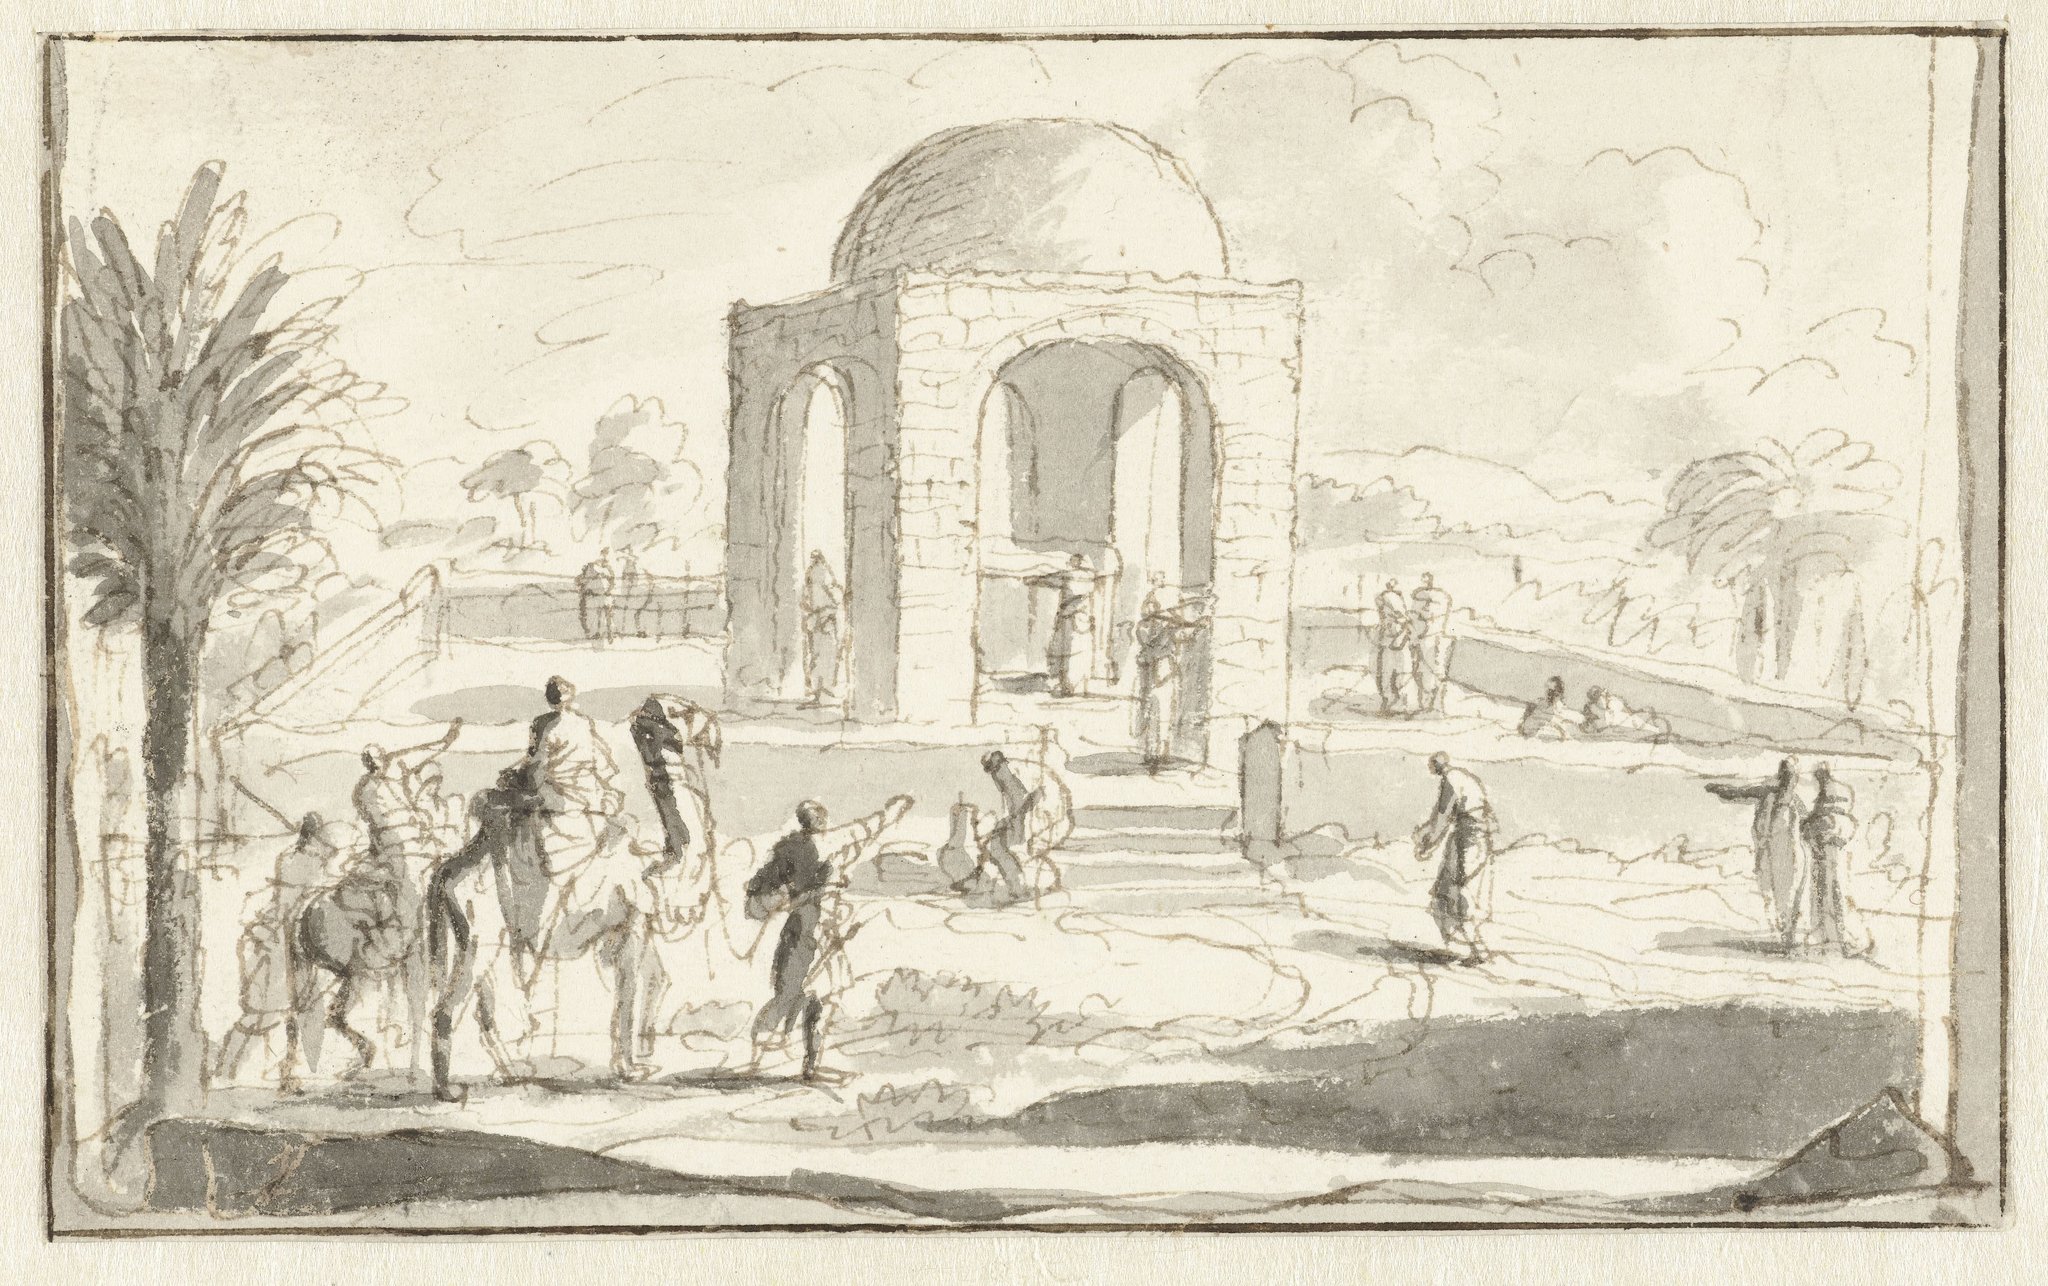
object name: drawing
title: Gezicht op een moskee of tempel in de woestijn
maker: jan luyken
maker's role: draughtsman, print maker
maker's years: 1649-1712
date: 1660-1712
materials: ink, paper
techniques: brush, pen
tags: desert, temple, shrine ~ islam, mohammedanism, temple, shrine ~ non-christian religions